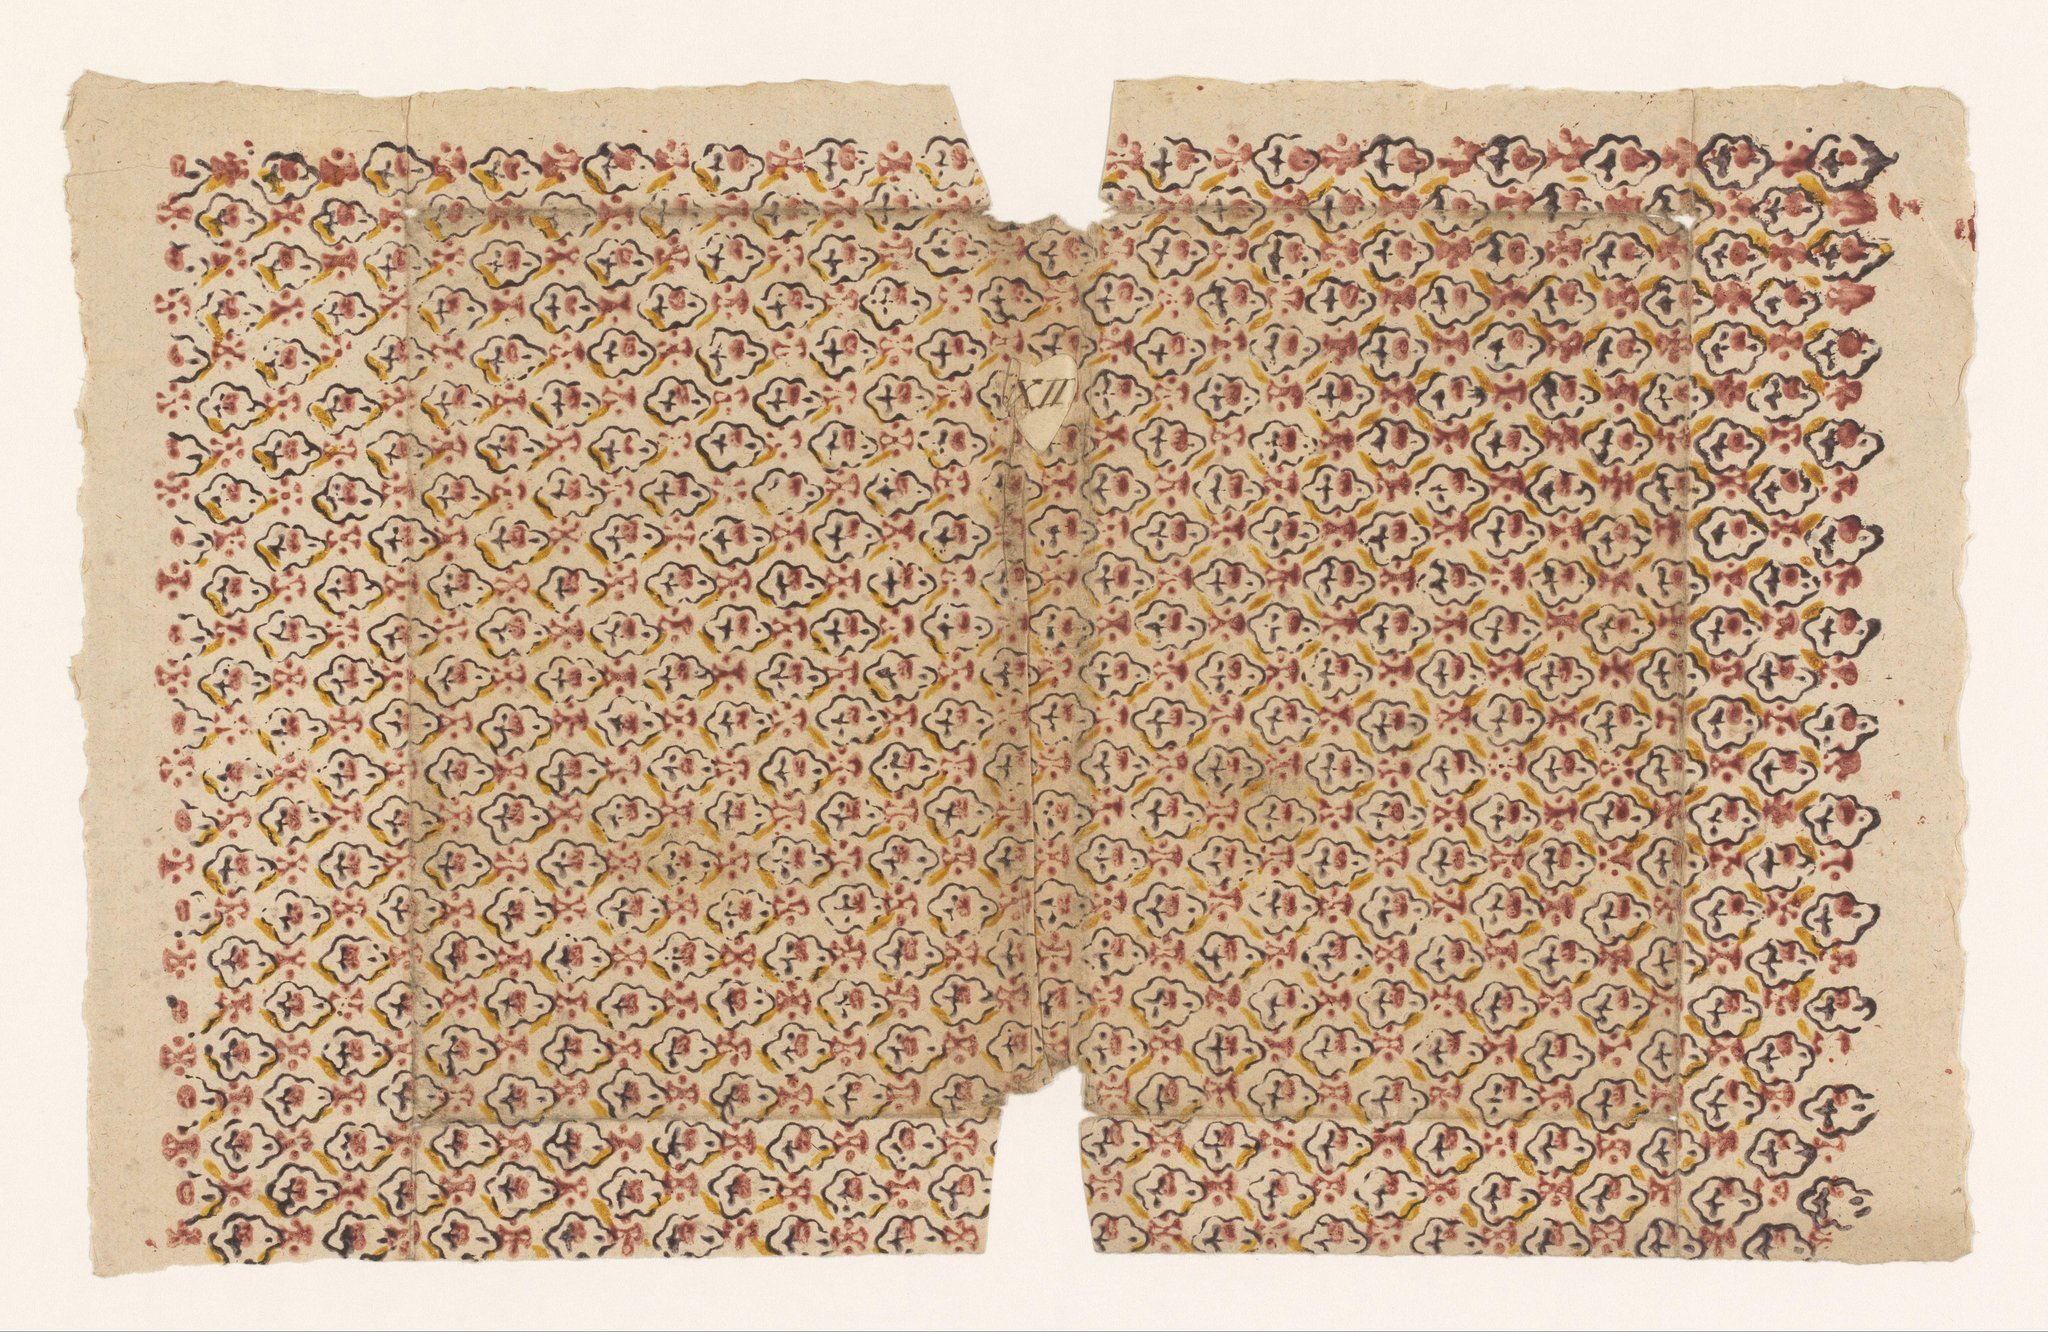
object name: wrapper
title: Blad met ruitenpatroon van geschulpt motief met bloem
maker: Anonymous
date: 1750-1900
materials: lacquer, paper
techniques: printing block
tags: ornament derived from plant forms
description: Blad met ruitenpatroon van geschulpt motief met bloem. Gebruikt als omslag, met etiket op rug.